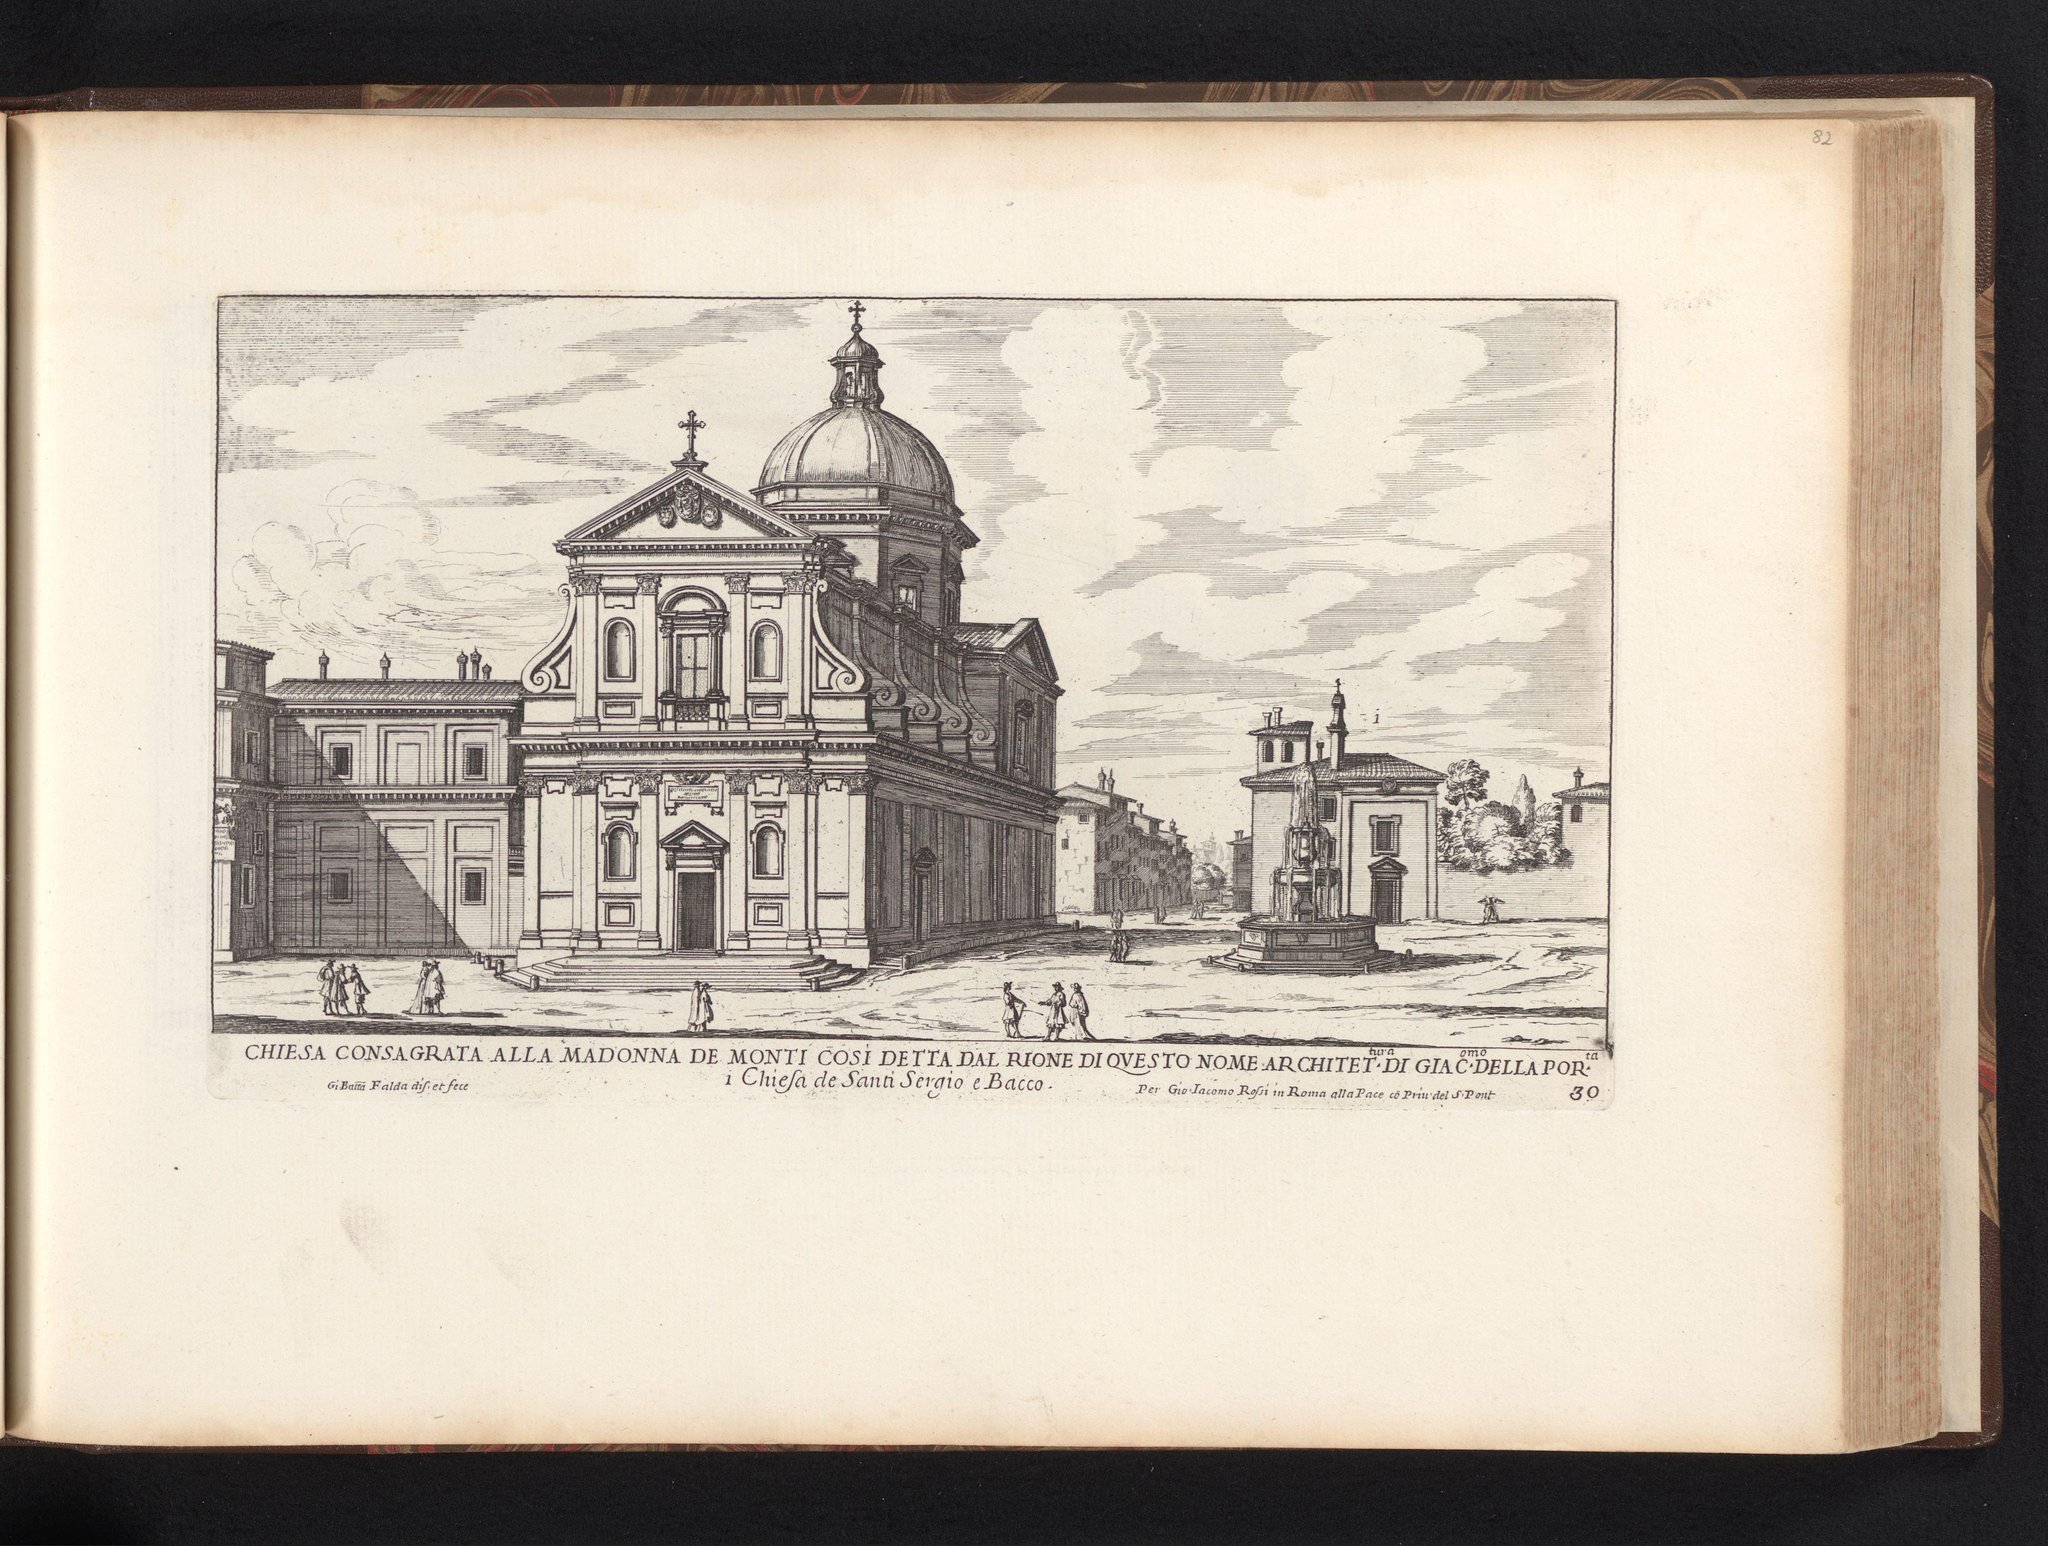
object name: album leaf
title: Chiesa consagrata alla Madonna de Monti cosi detta dal rione di questo nom (...)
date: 1669-1670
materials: paper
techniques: etching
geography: rome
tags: city-view, and landscape with man-made constructions, church (exterior)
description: Deze titelprent maakt deel uit van een reeks van 38 prenten met voorstellingen van kerken in Rome. Samen met vier andere reeksen vormt het de grote reeks: 'Il nuovo teatro di Roma moderna'.